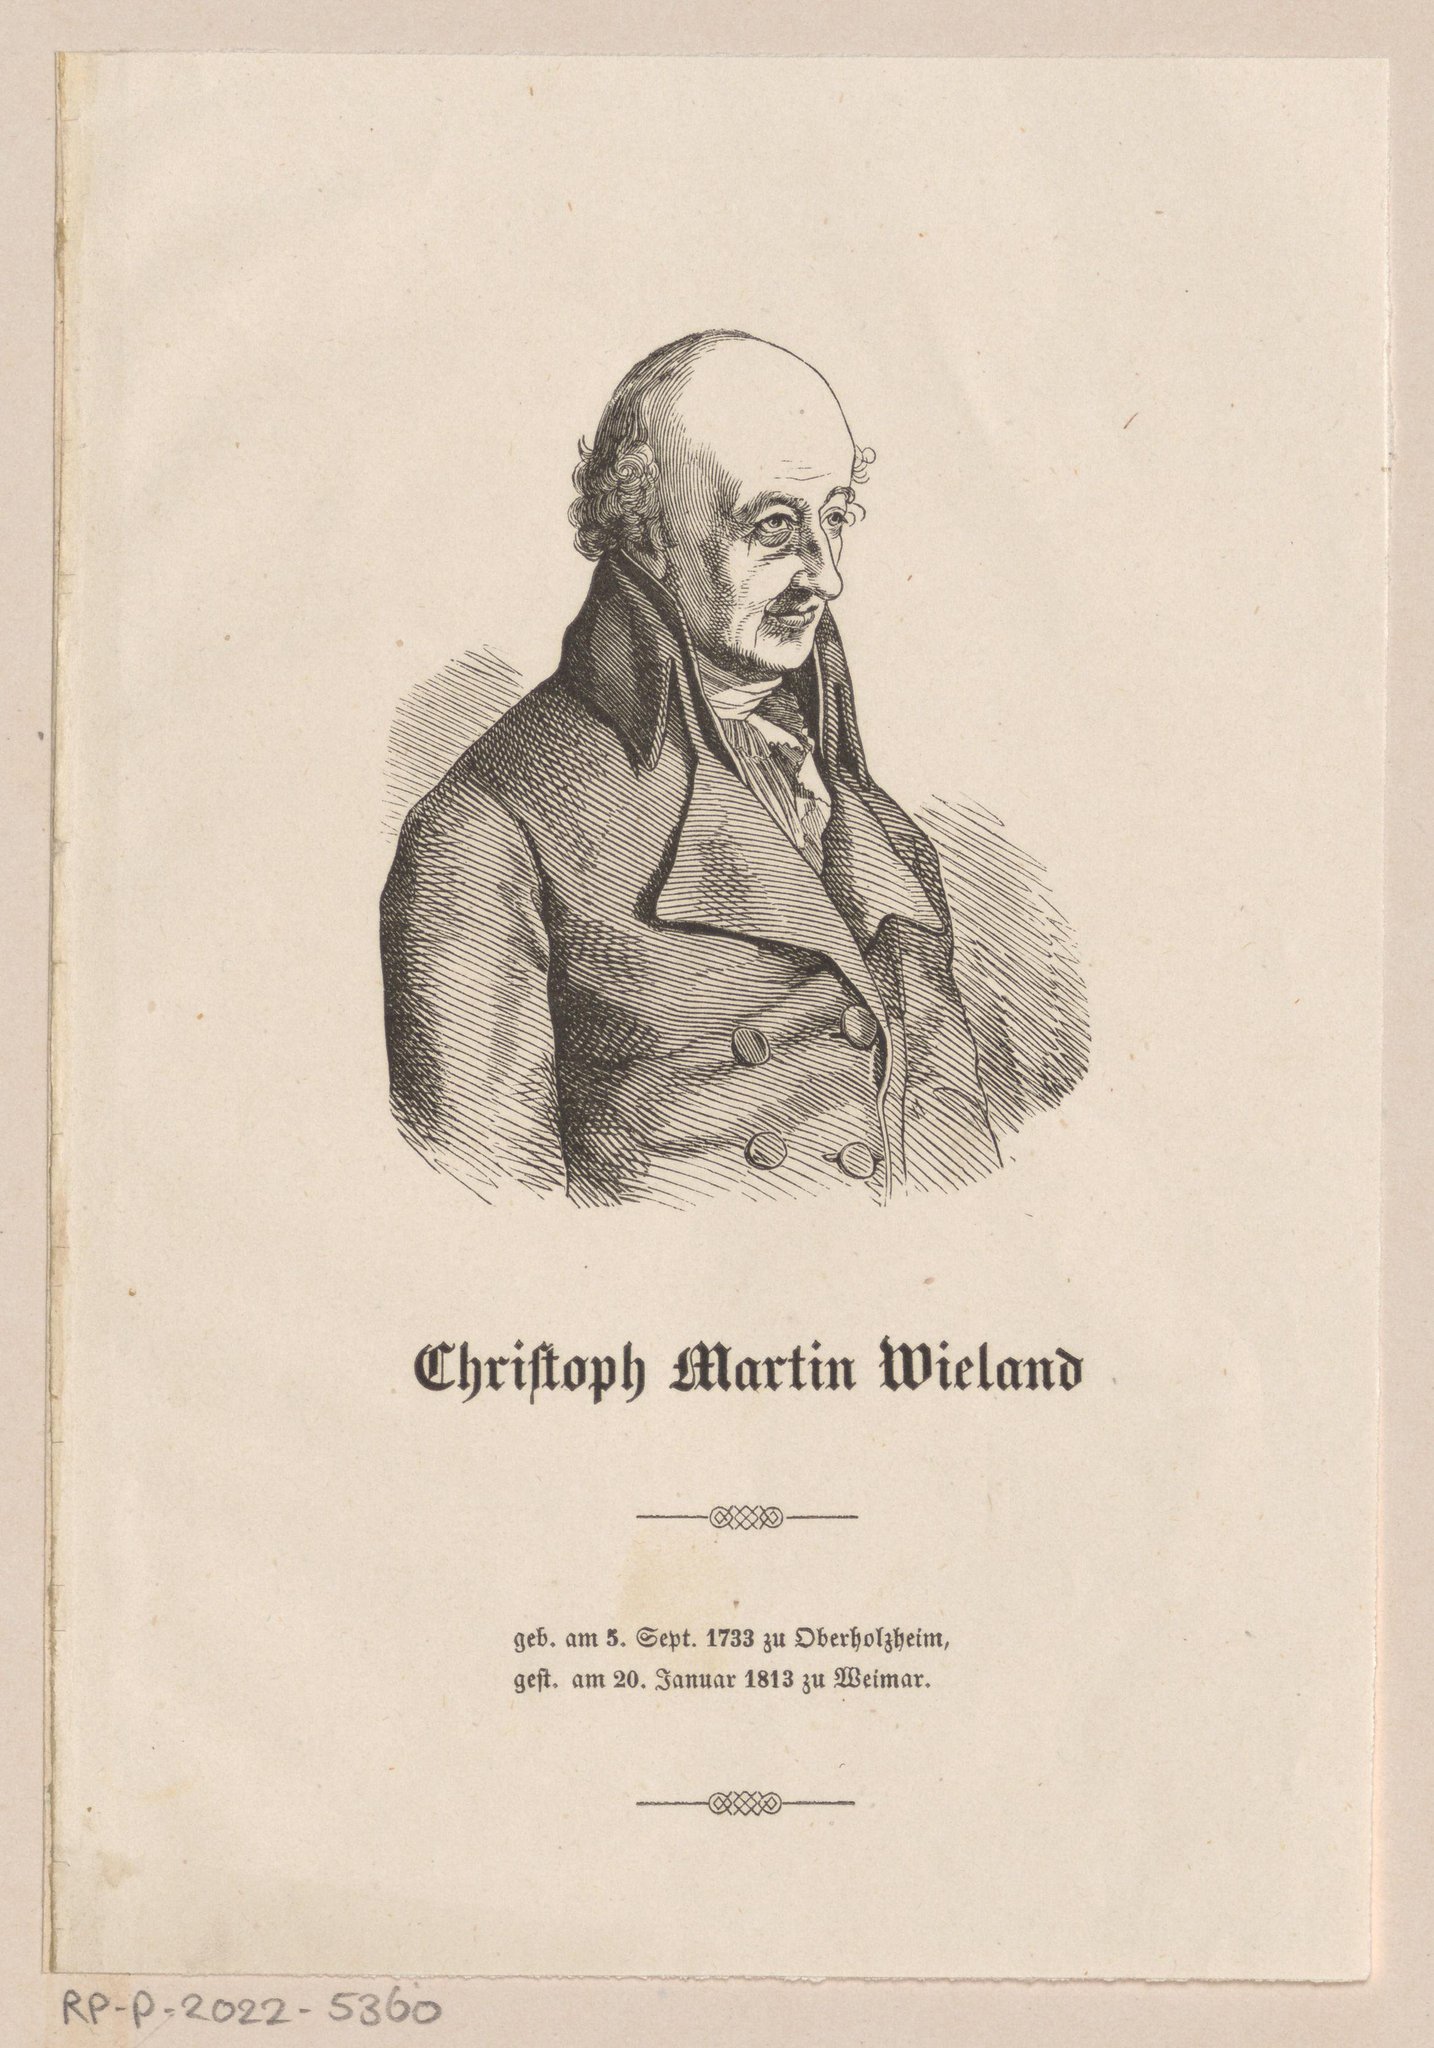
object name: print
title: Portret van Christoph Martin Wieland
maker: Anonymous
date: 1813-1899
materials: paper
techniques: letterpress printing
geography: germany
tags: publisher, christoph martin wieland, historical persons, writer, poet, author